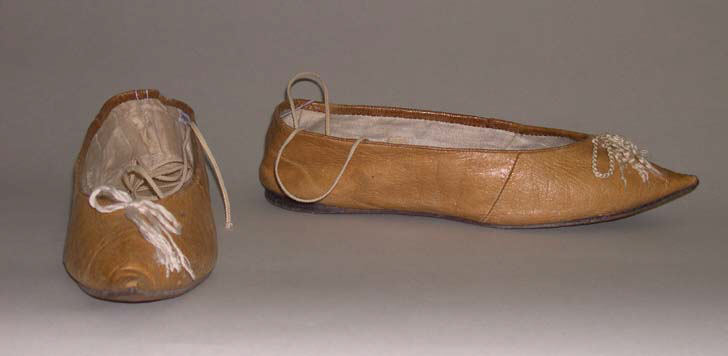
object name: slipper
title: Slippers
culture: american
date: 1790-1800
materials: leather, linen, silk